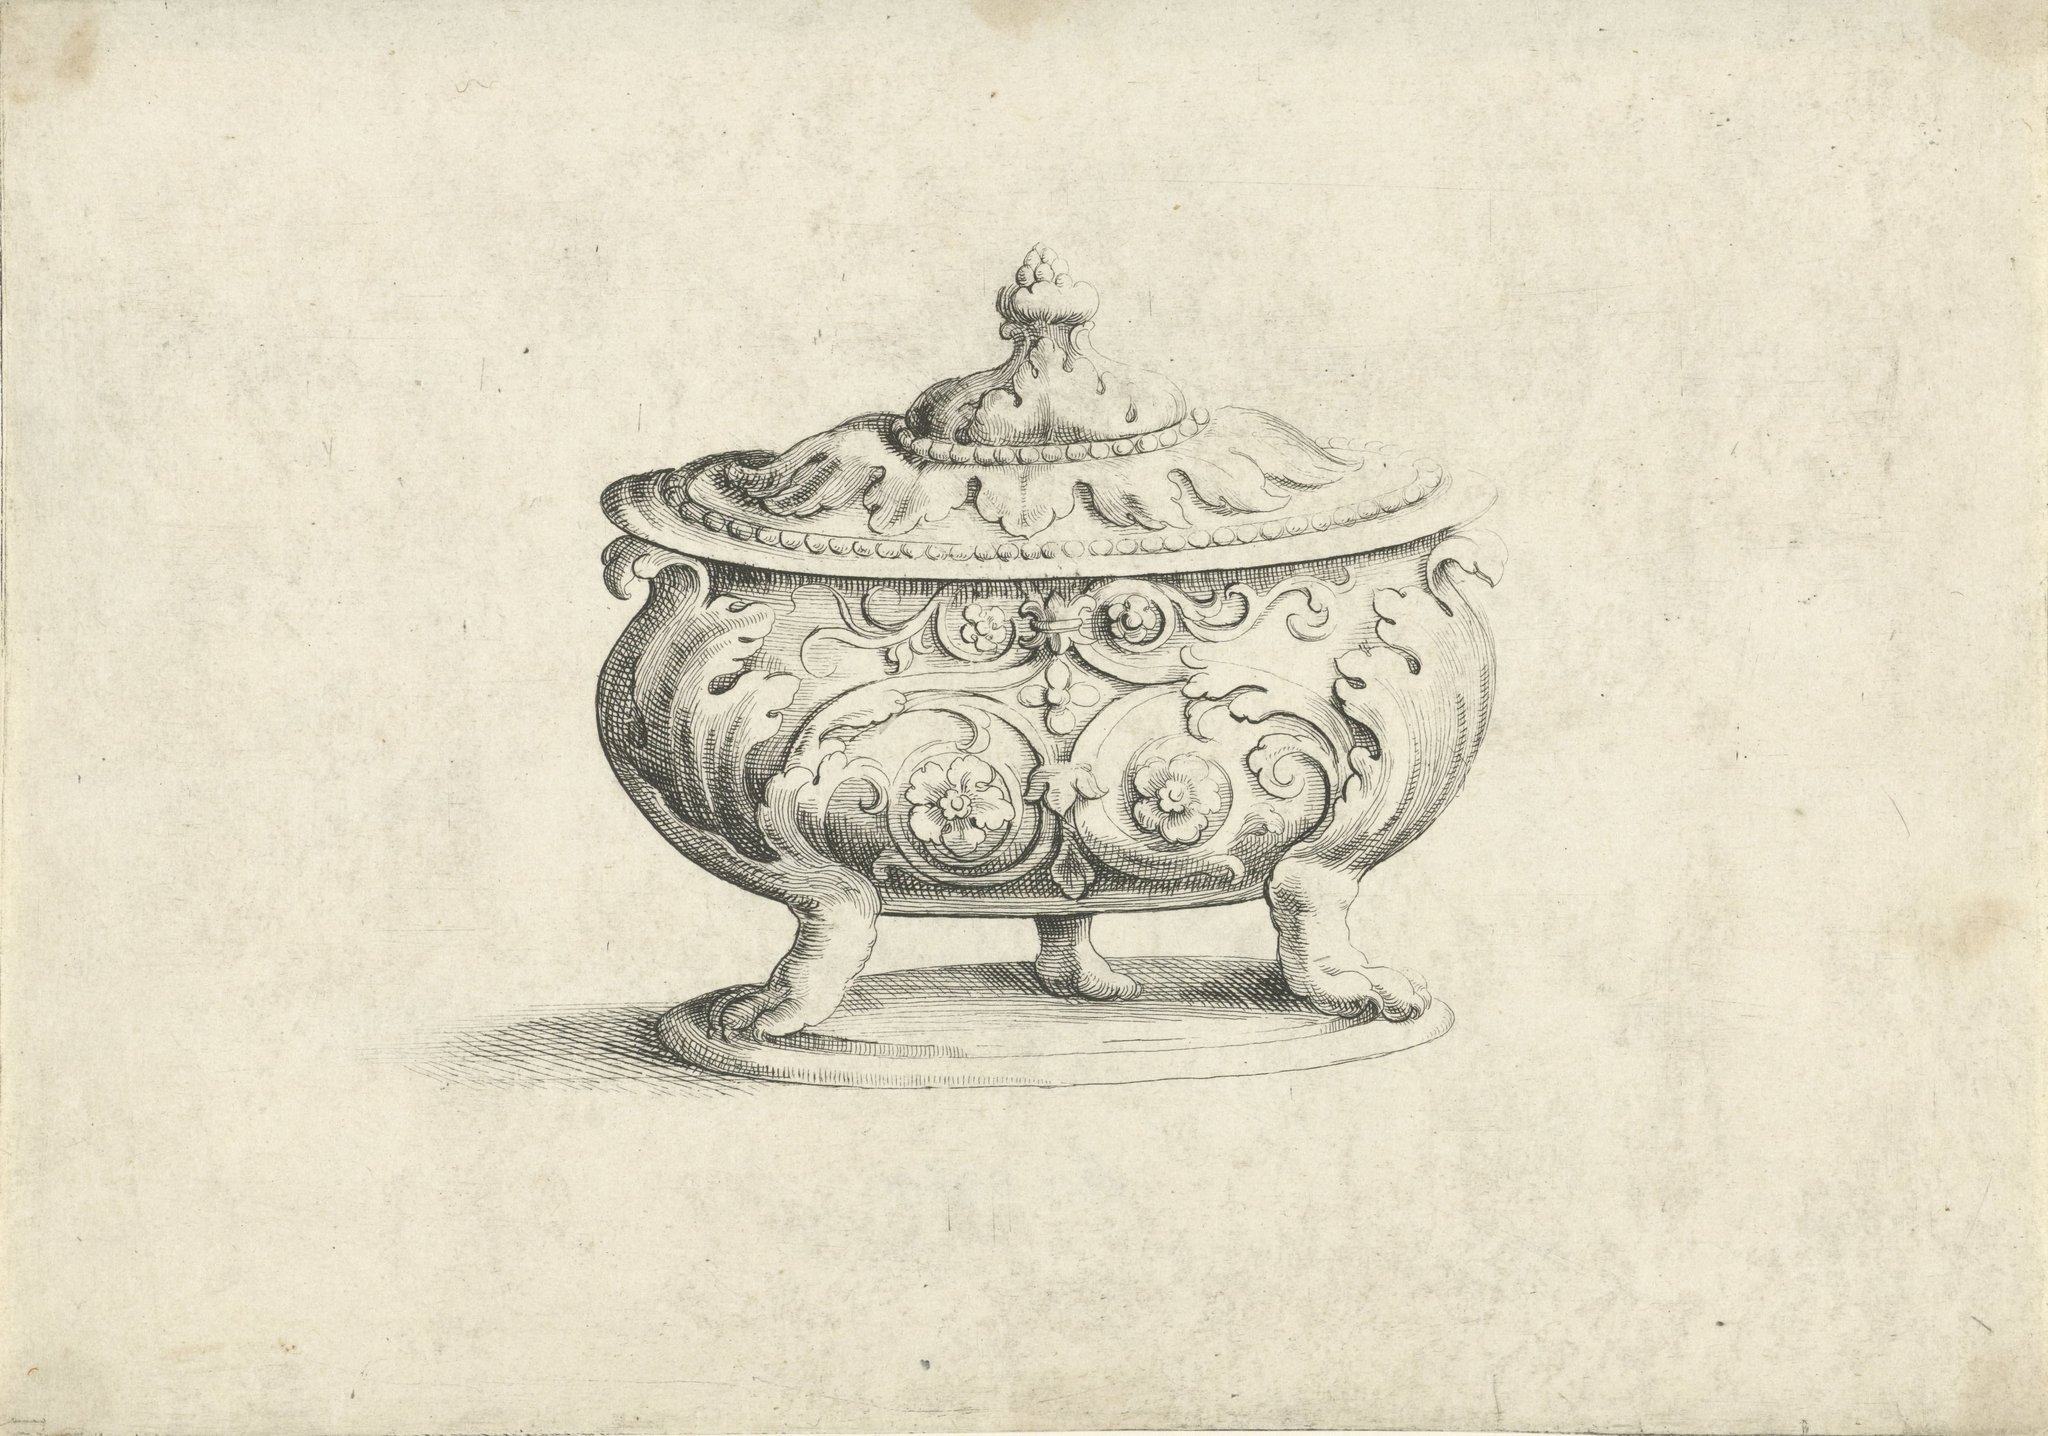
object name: print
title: Ne intuearis vinum quando flauescit (...)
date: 1614-1654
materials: paper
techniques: etching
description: Uit serie van 14 bladen met schalen, kommen en kistjes.